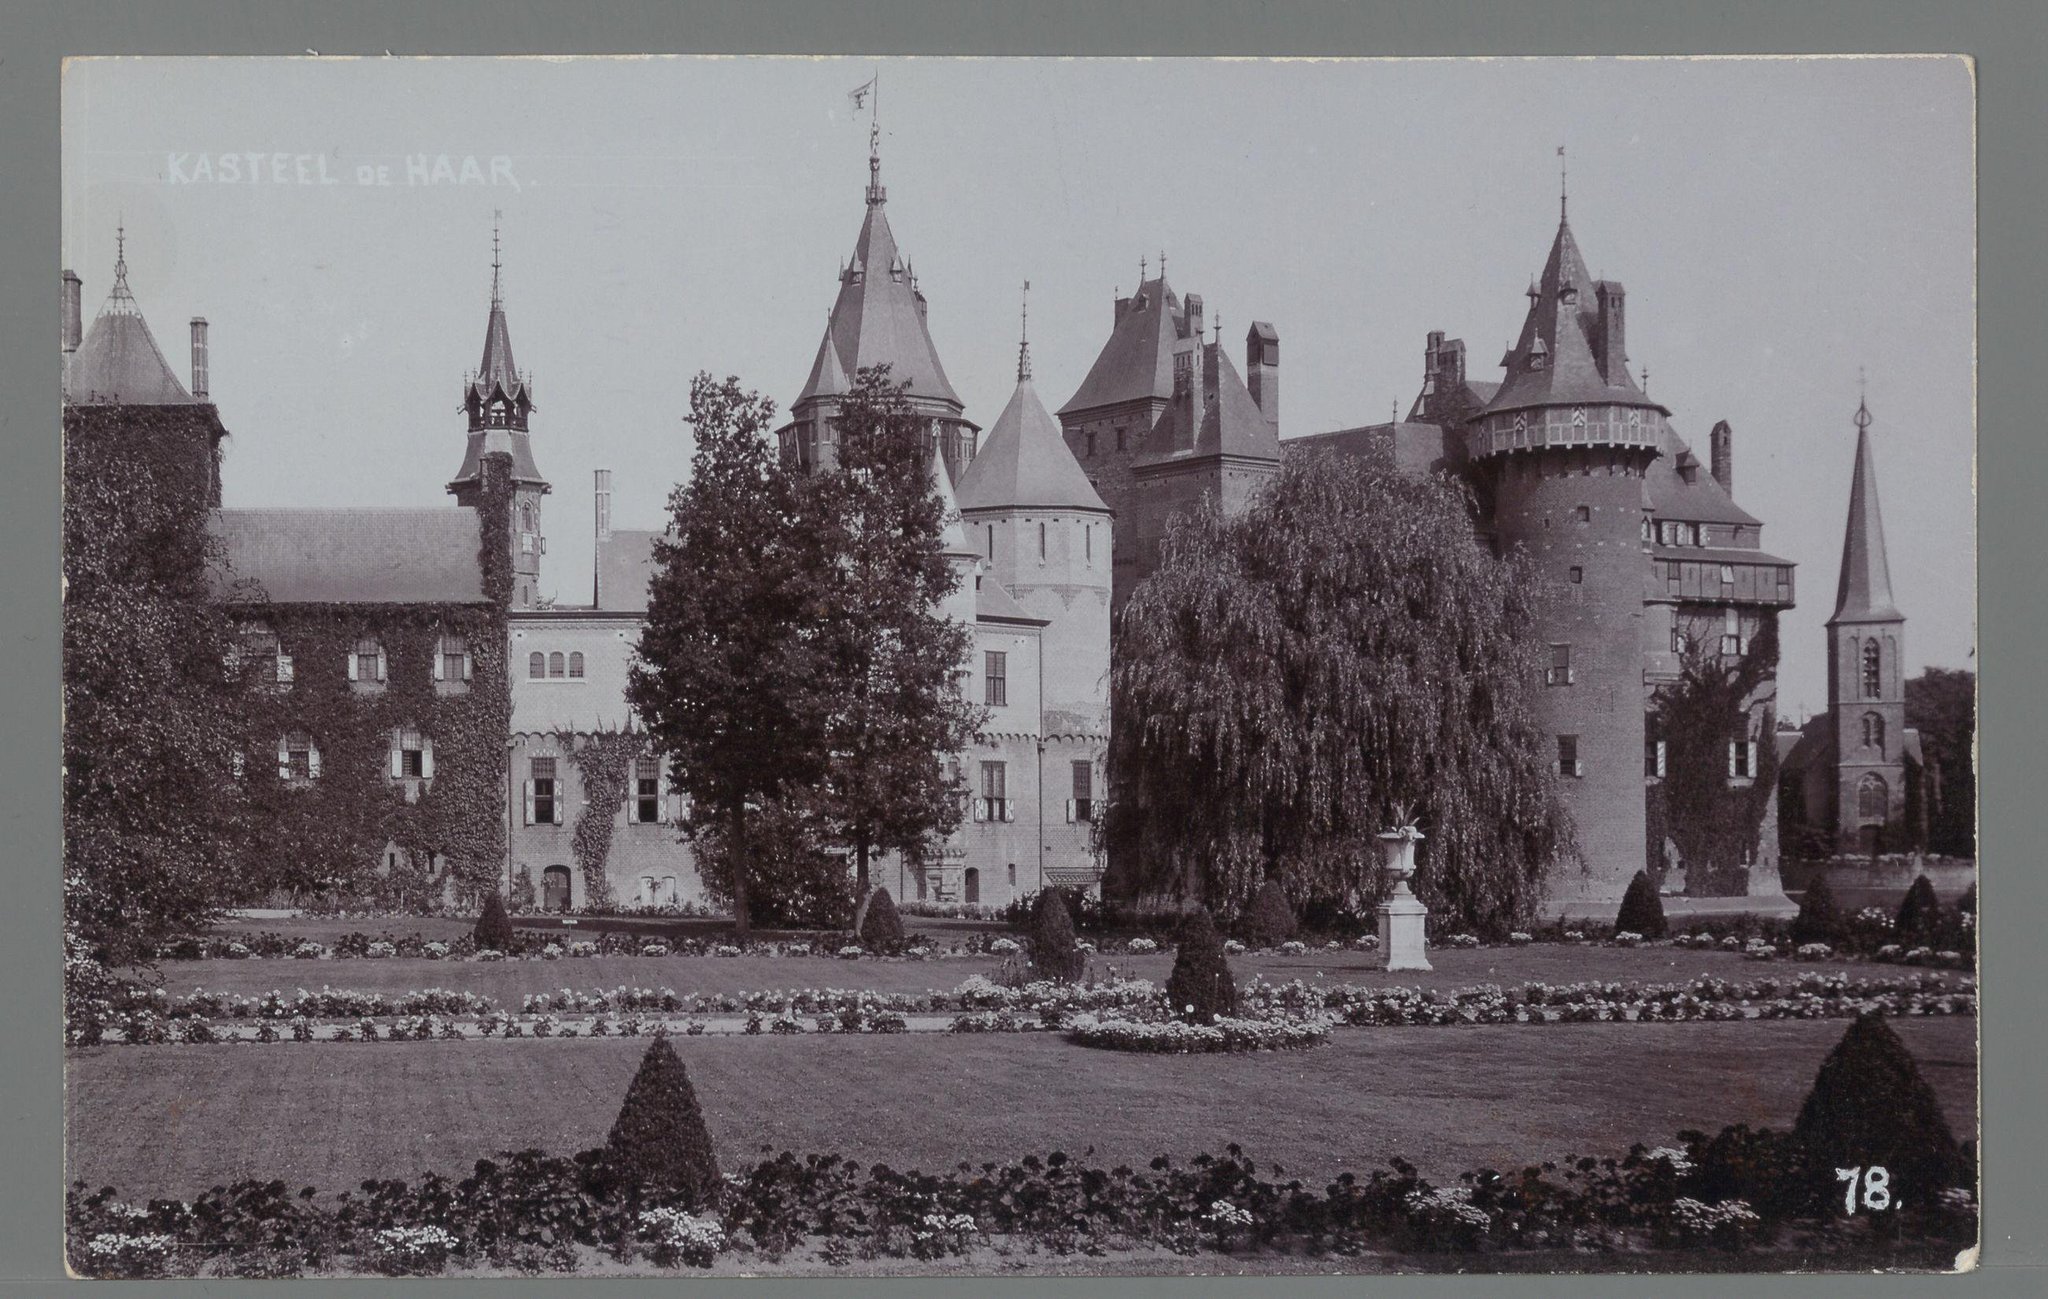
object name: photograph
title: Kasteel de Haar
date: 1900-1930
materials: paper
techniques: collodion silver print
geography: haarzuilens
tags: castle, church (exterior)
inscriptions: monogram: ‘M.R.A. U.’